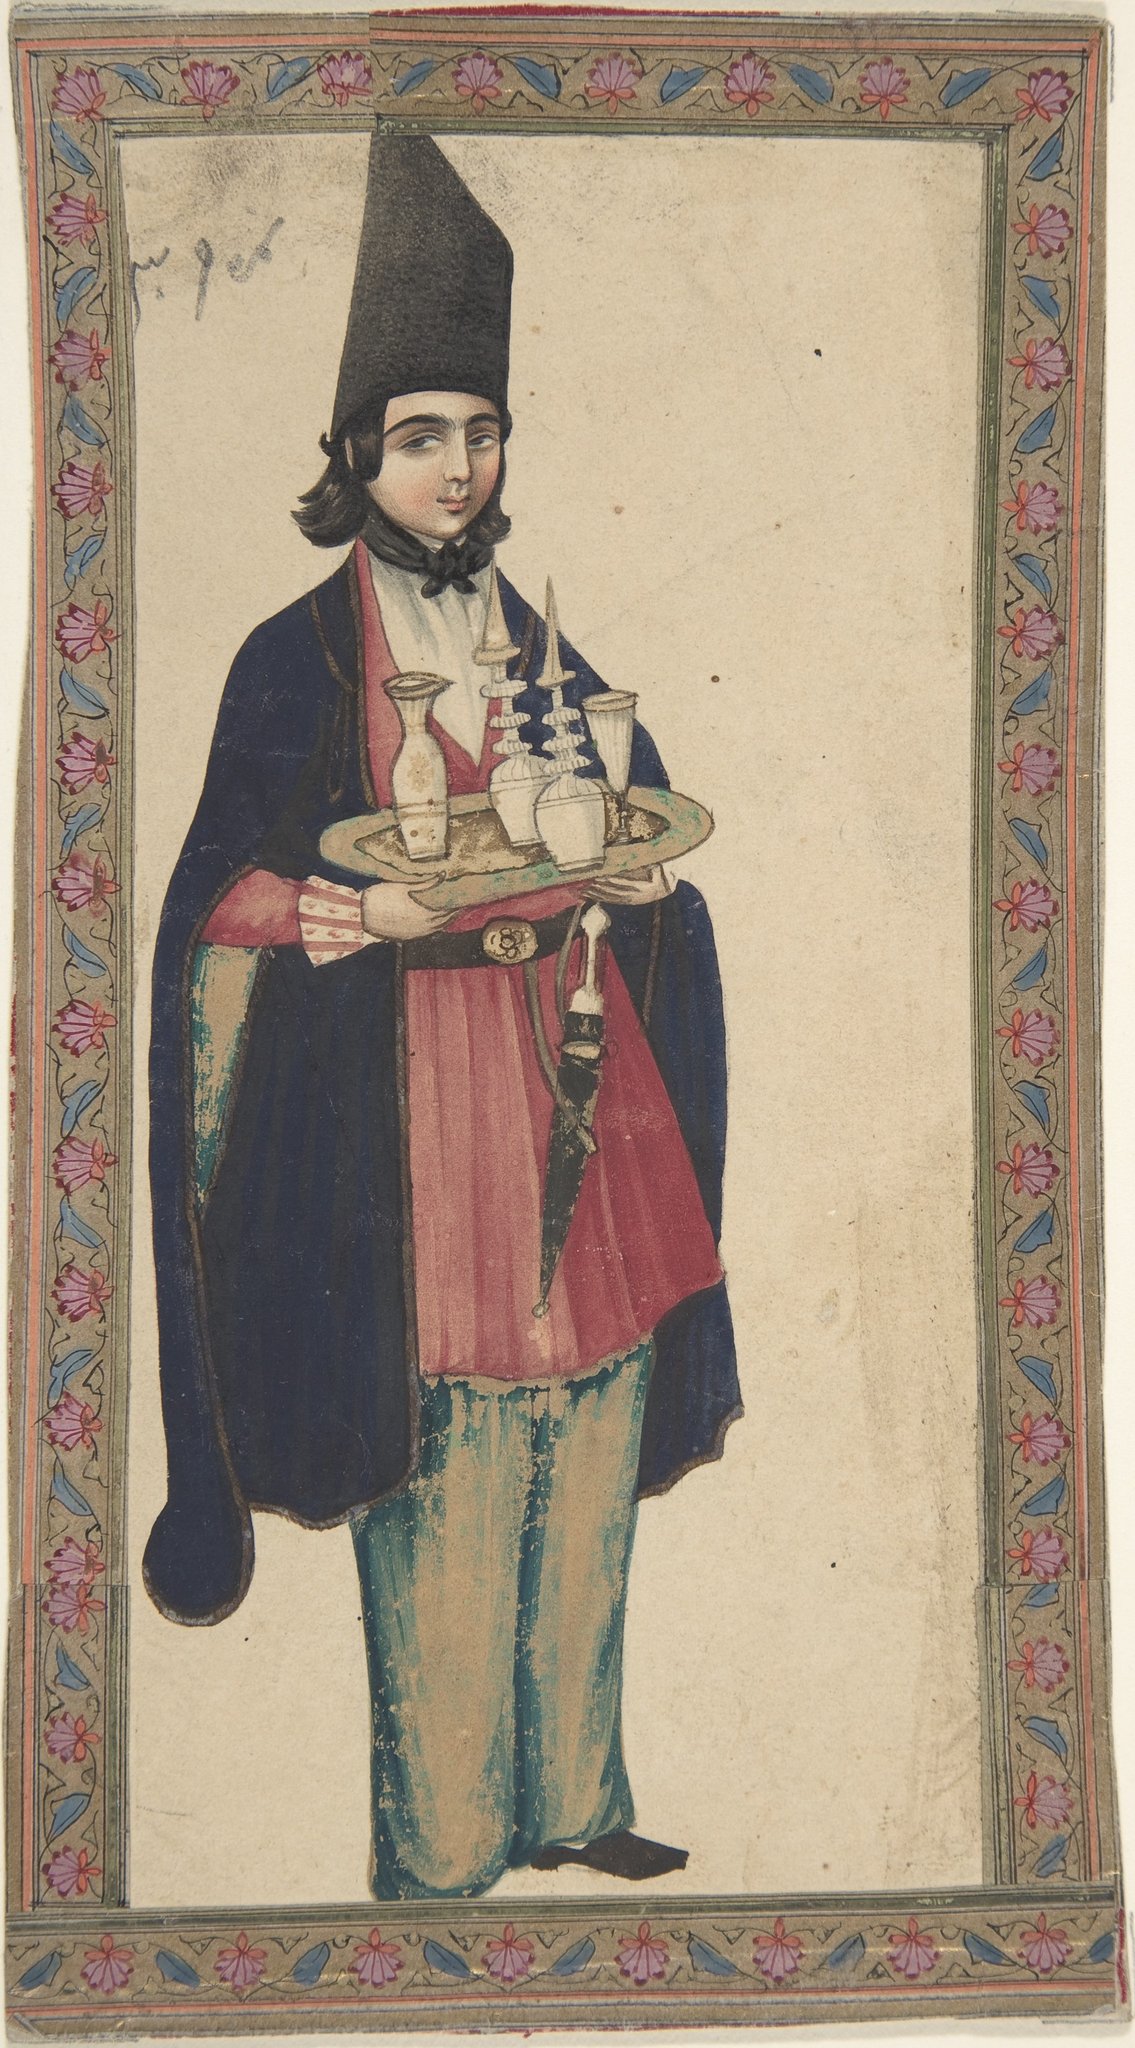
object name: drawing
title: Persian Woman or Man Holding a Tray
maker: anonymous, persian, 19th century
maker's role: artist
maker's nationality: persian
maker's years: 1800-1900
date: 1801-1900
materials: gouache, watercolor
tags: human figures,trays